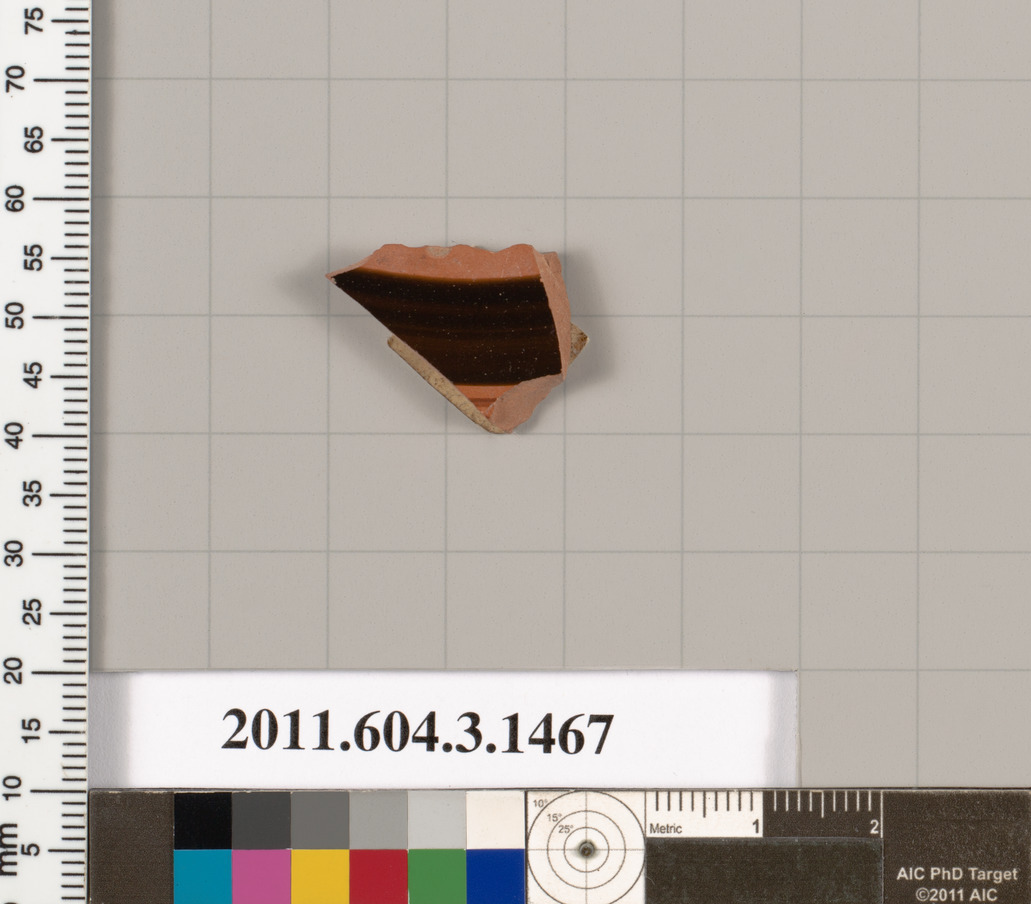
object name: skyphos fragment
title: Terracotta fragment of a skyphos (deep drinking cup)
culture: greek, attic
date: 600-401 BCE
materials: terracotta